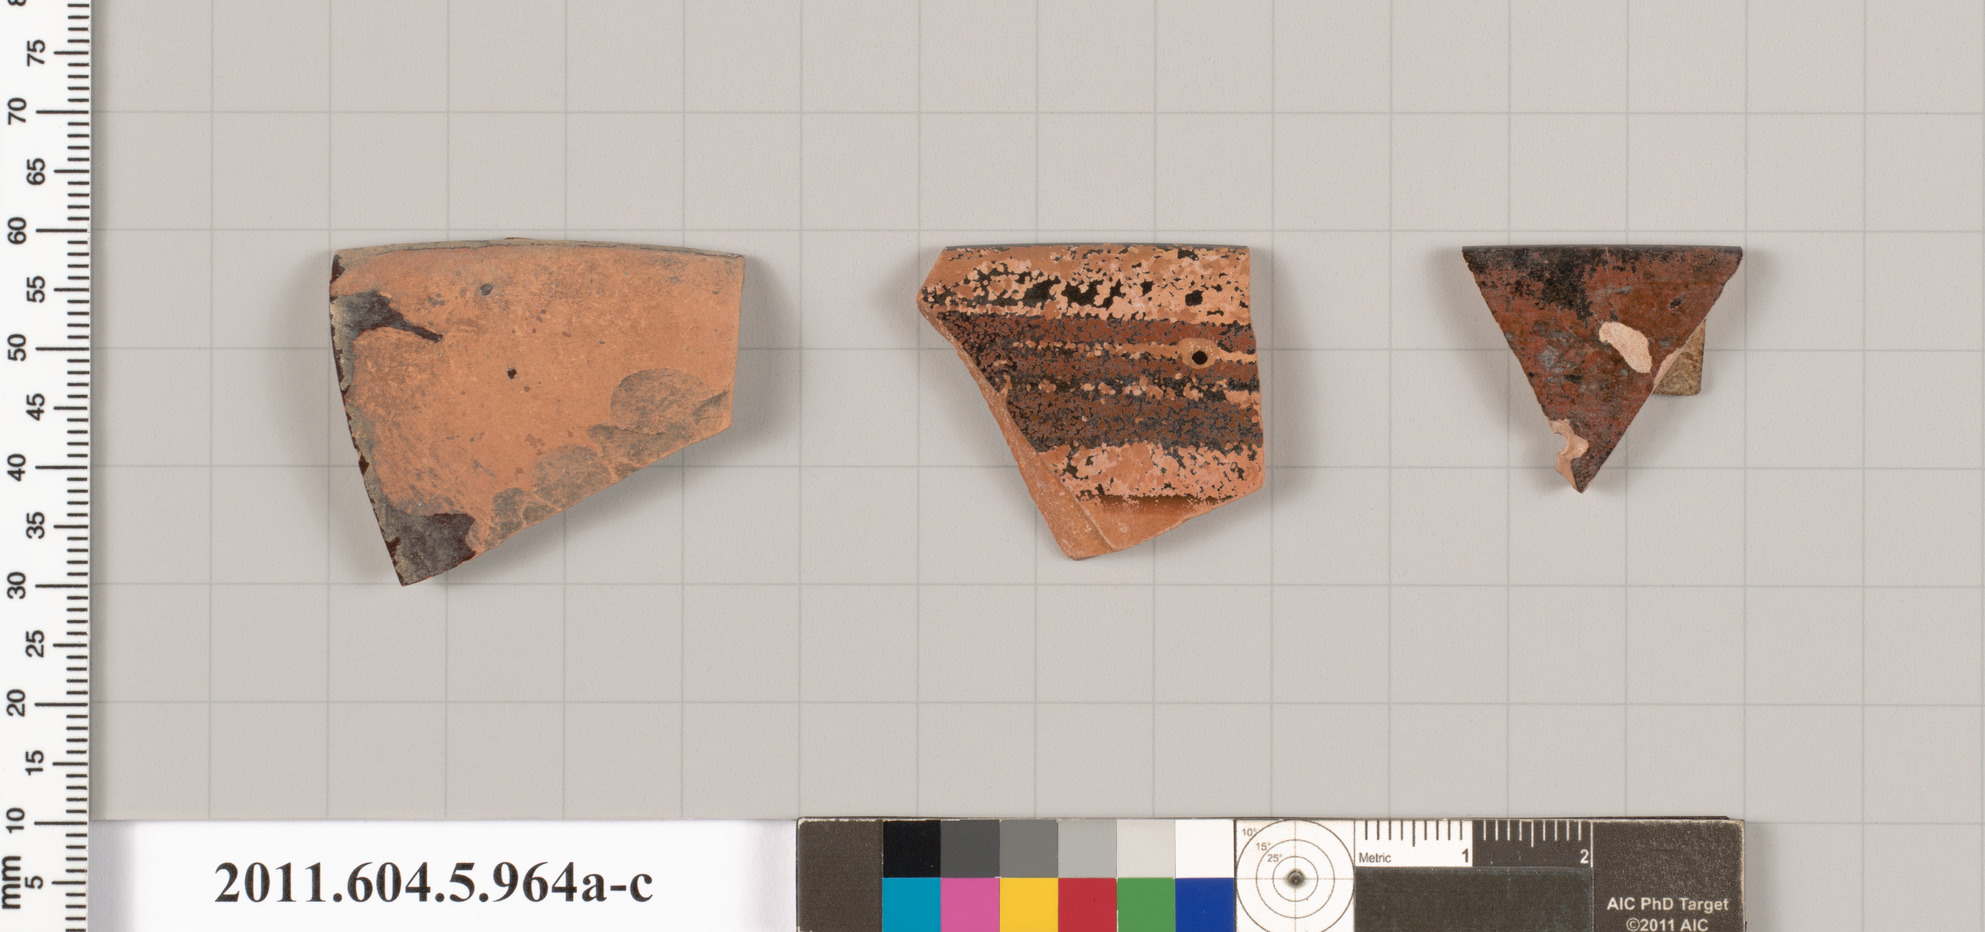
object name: kylix fragment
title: Terracotta rim fragments of kylikes (drinking cups)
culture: greek, attic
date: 600-401 BCE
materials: terracotta